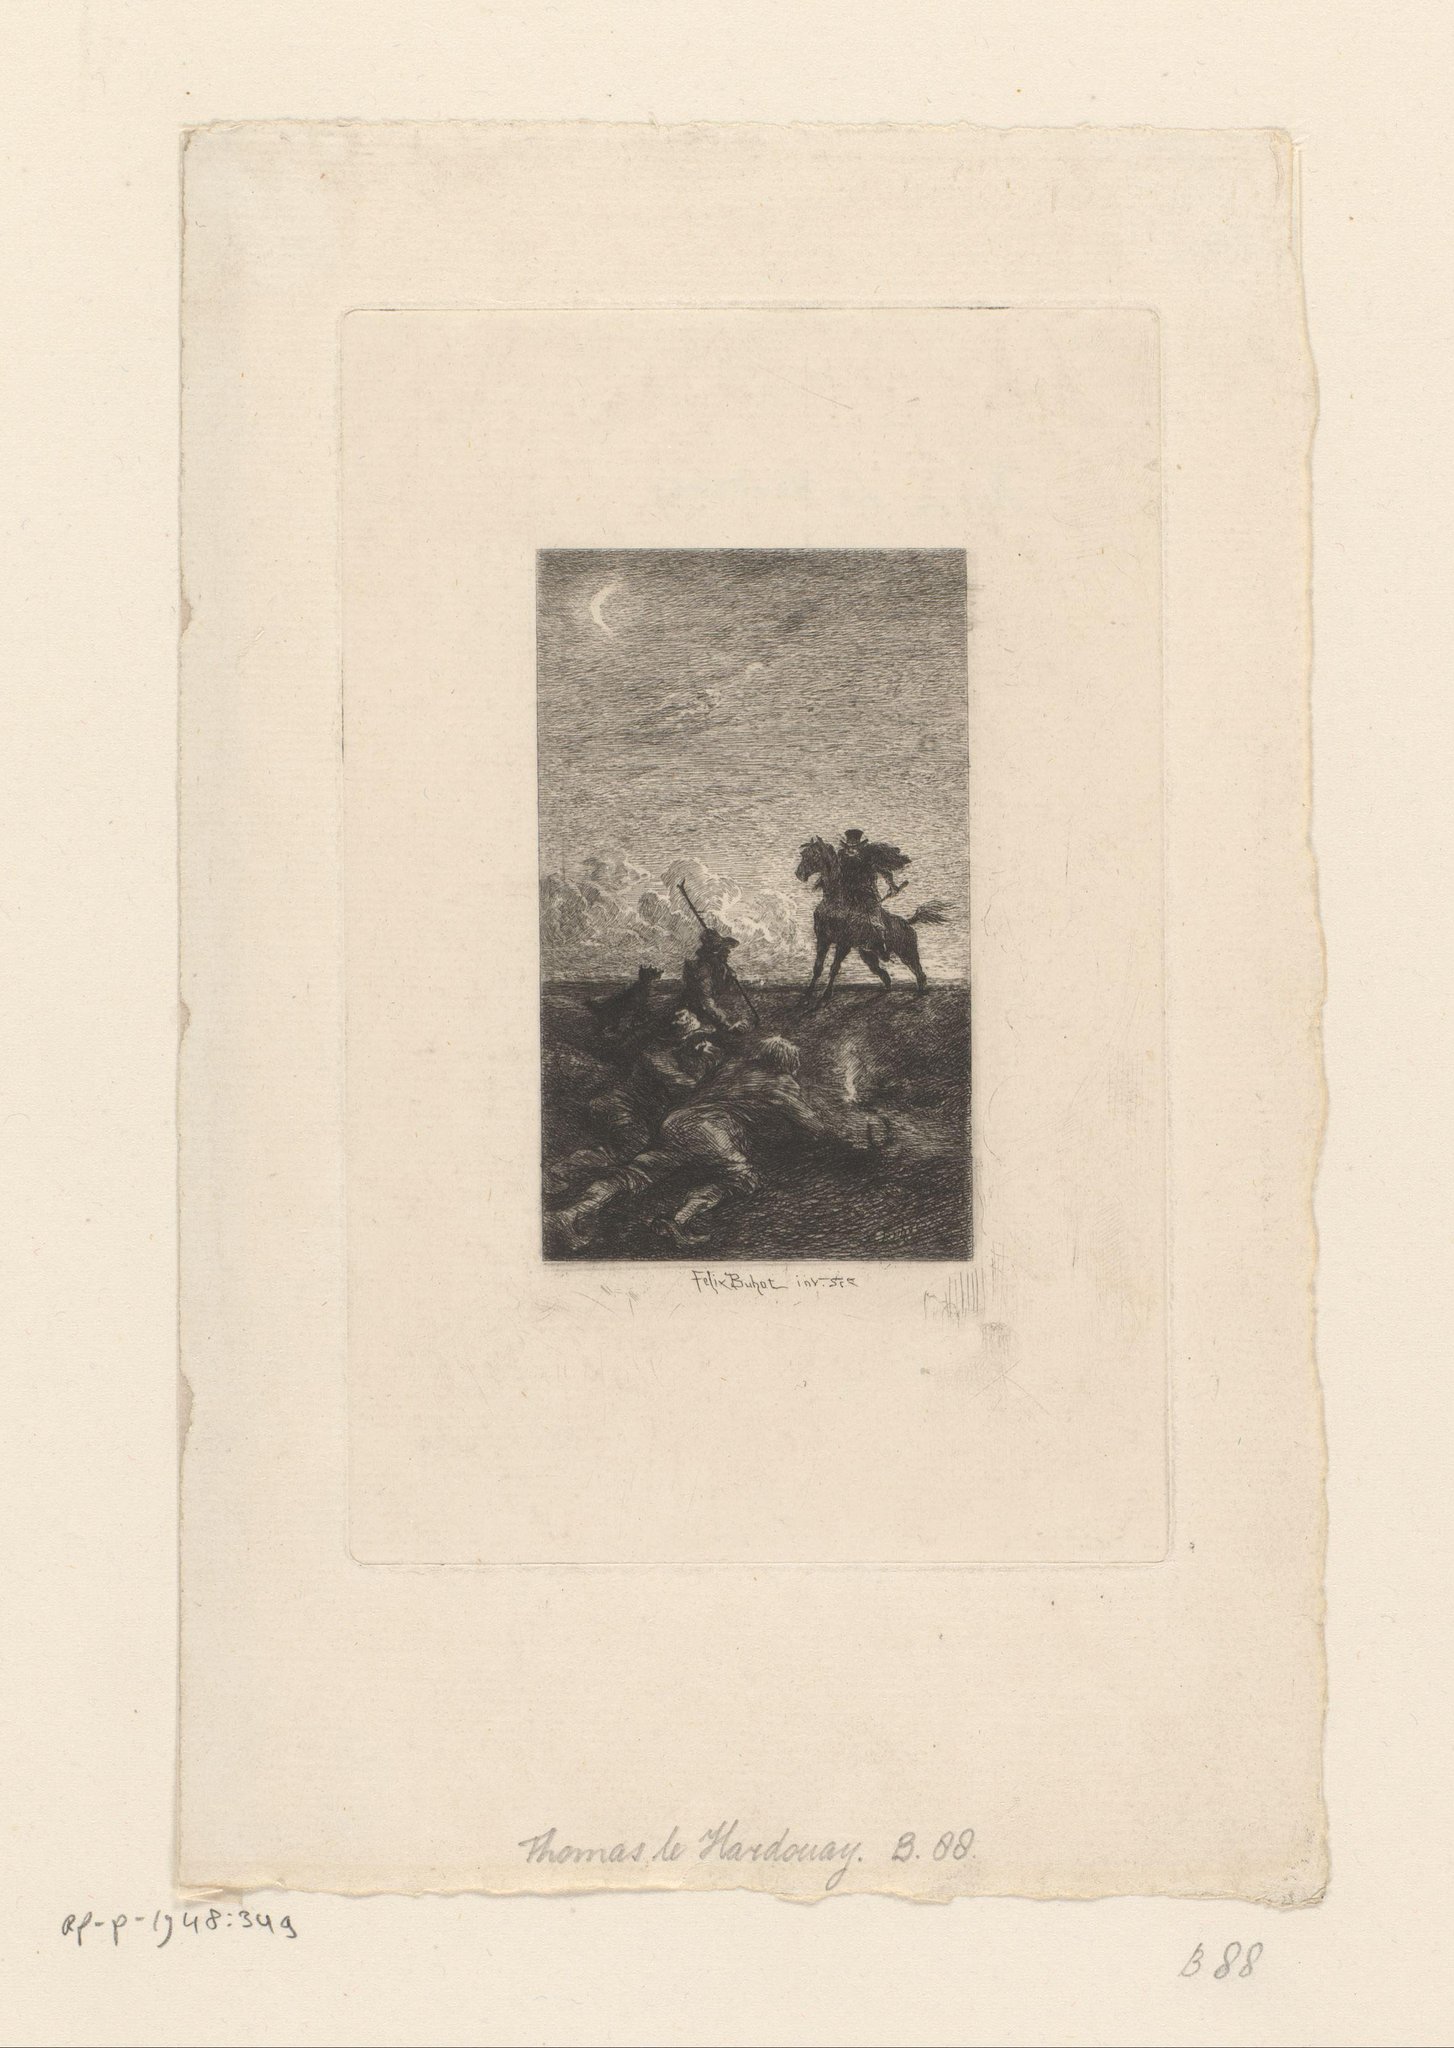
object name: print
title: Ruiter valt een groep mannen aan in de nacht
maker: félix hilaire buhot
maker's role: draughtsman, print maker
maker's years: 1847-1898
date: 1857-1898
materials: paper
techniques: etching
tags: riding a horse, ass, or mule; rider, horseman, night, attack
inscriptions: : ‘Thomas le Hardouay. B. 88.’